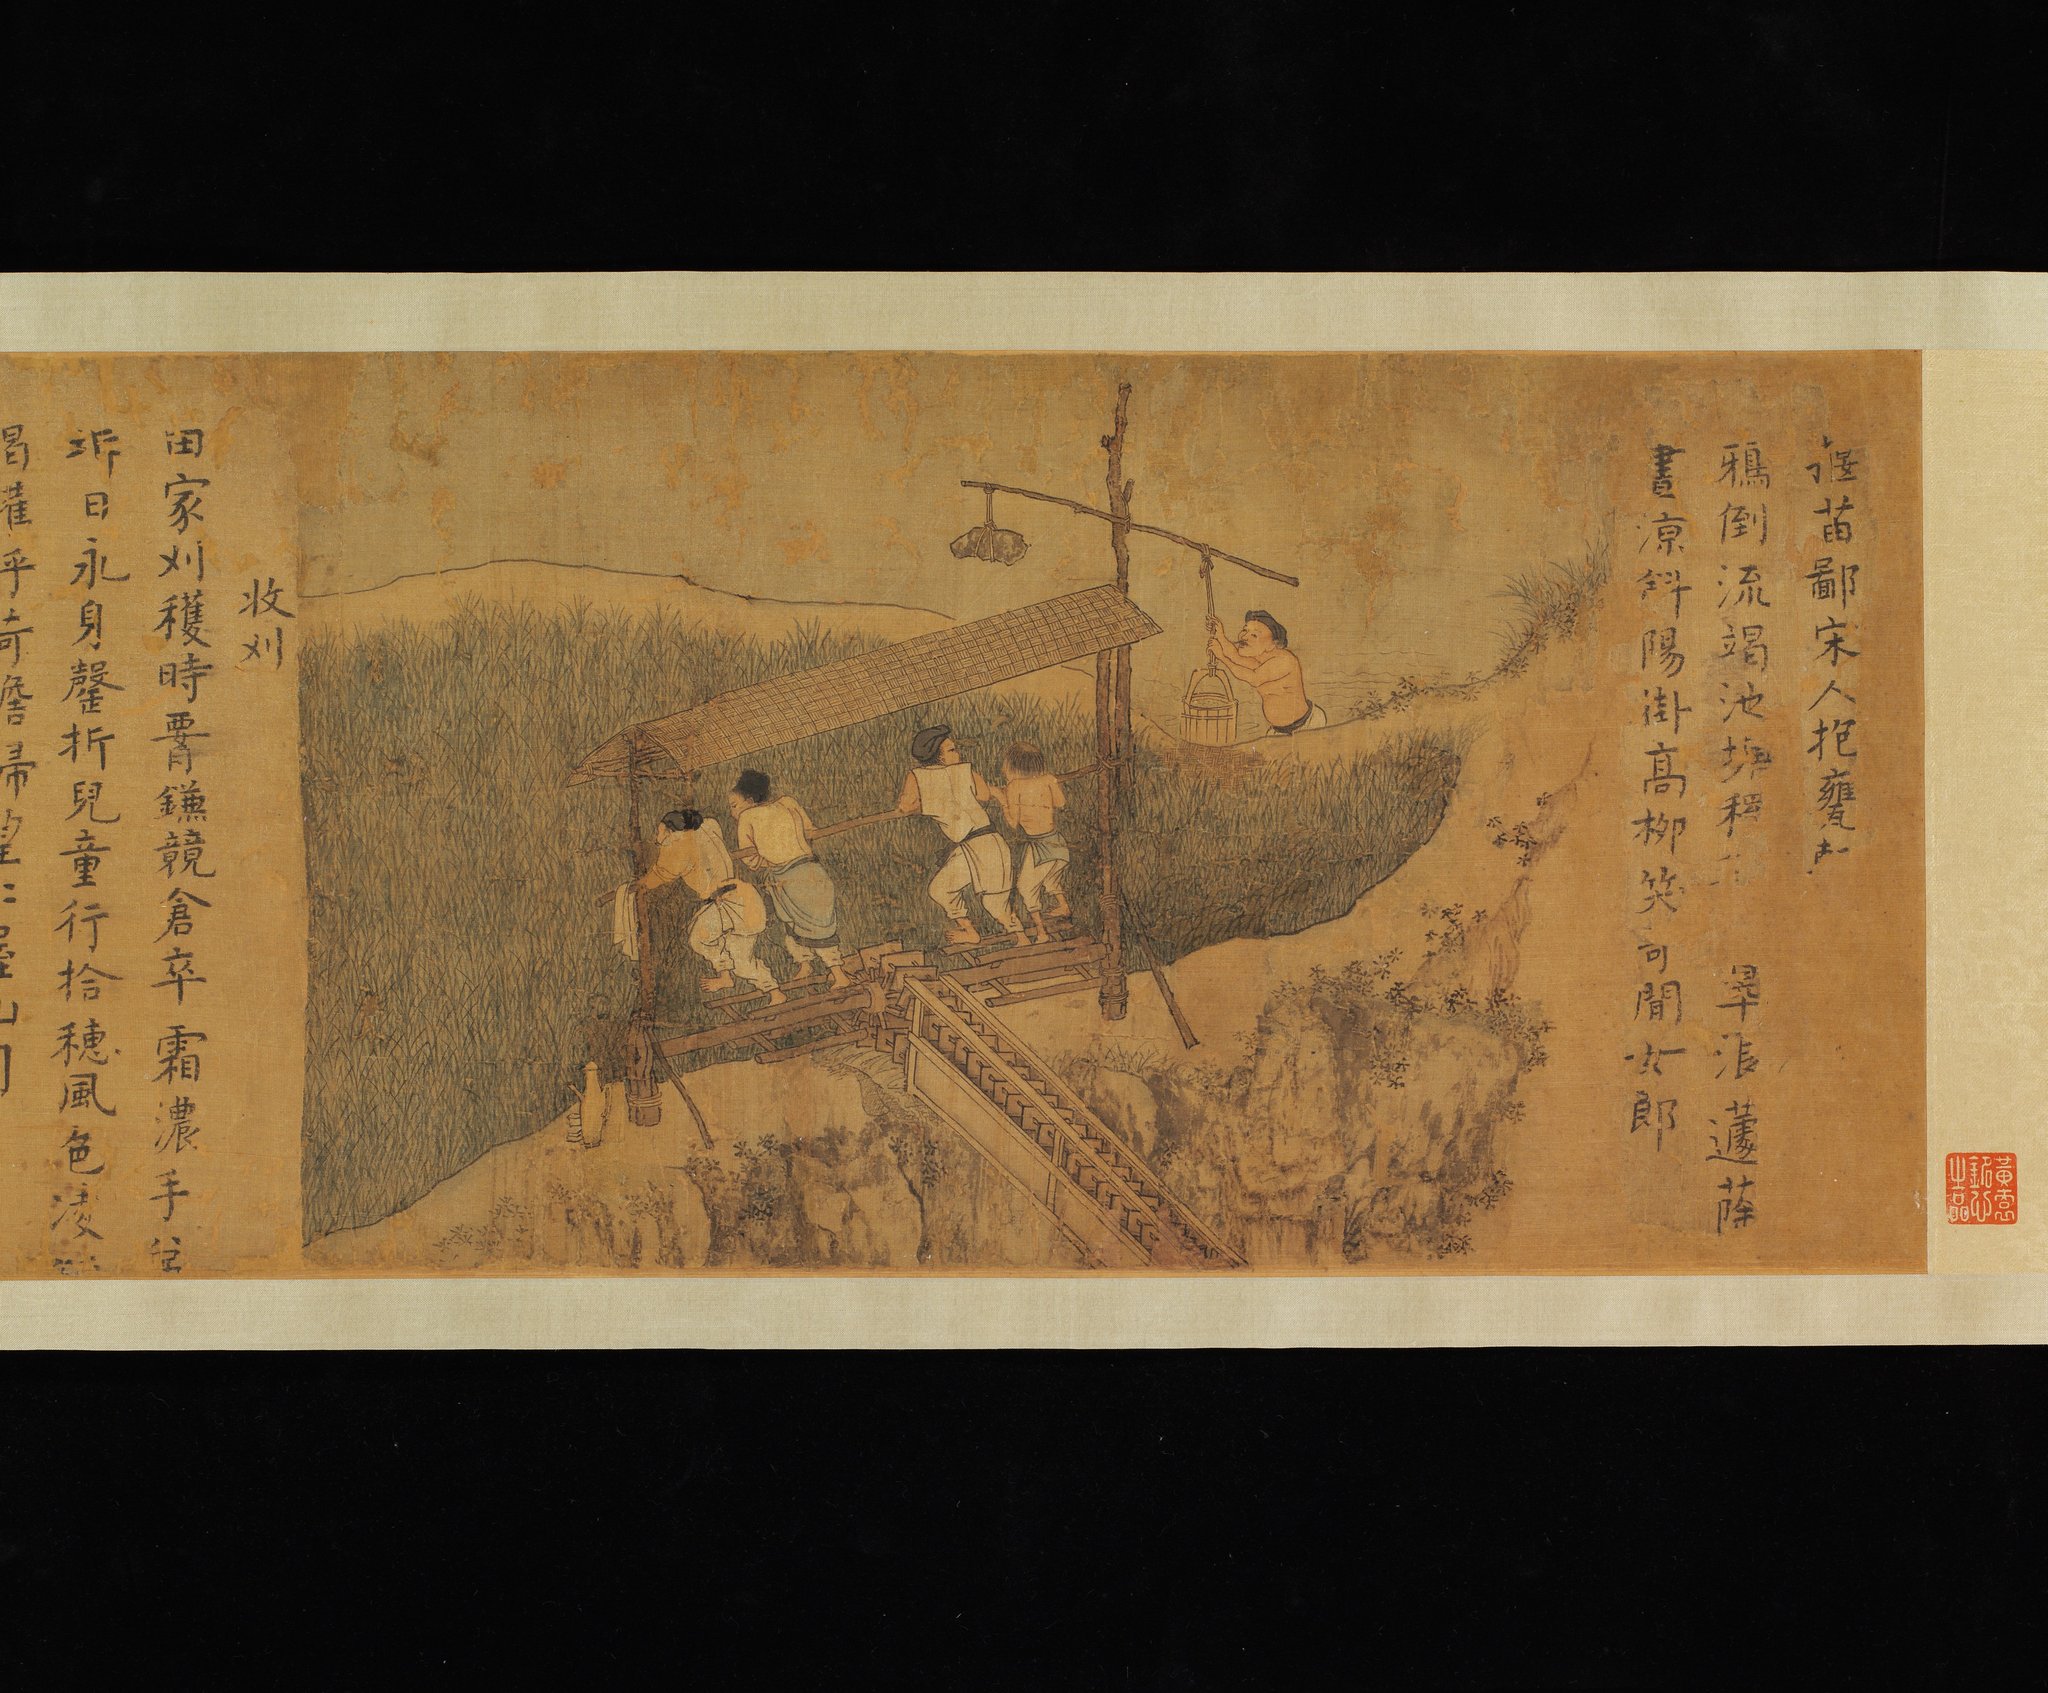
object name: handscroll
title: Rice Culture, or Sowing and Reaping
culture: chinese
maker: unidentified artist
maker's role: artist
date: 1353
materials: ink, silk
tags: men,working,farmers